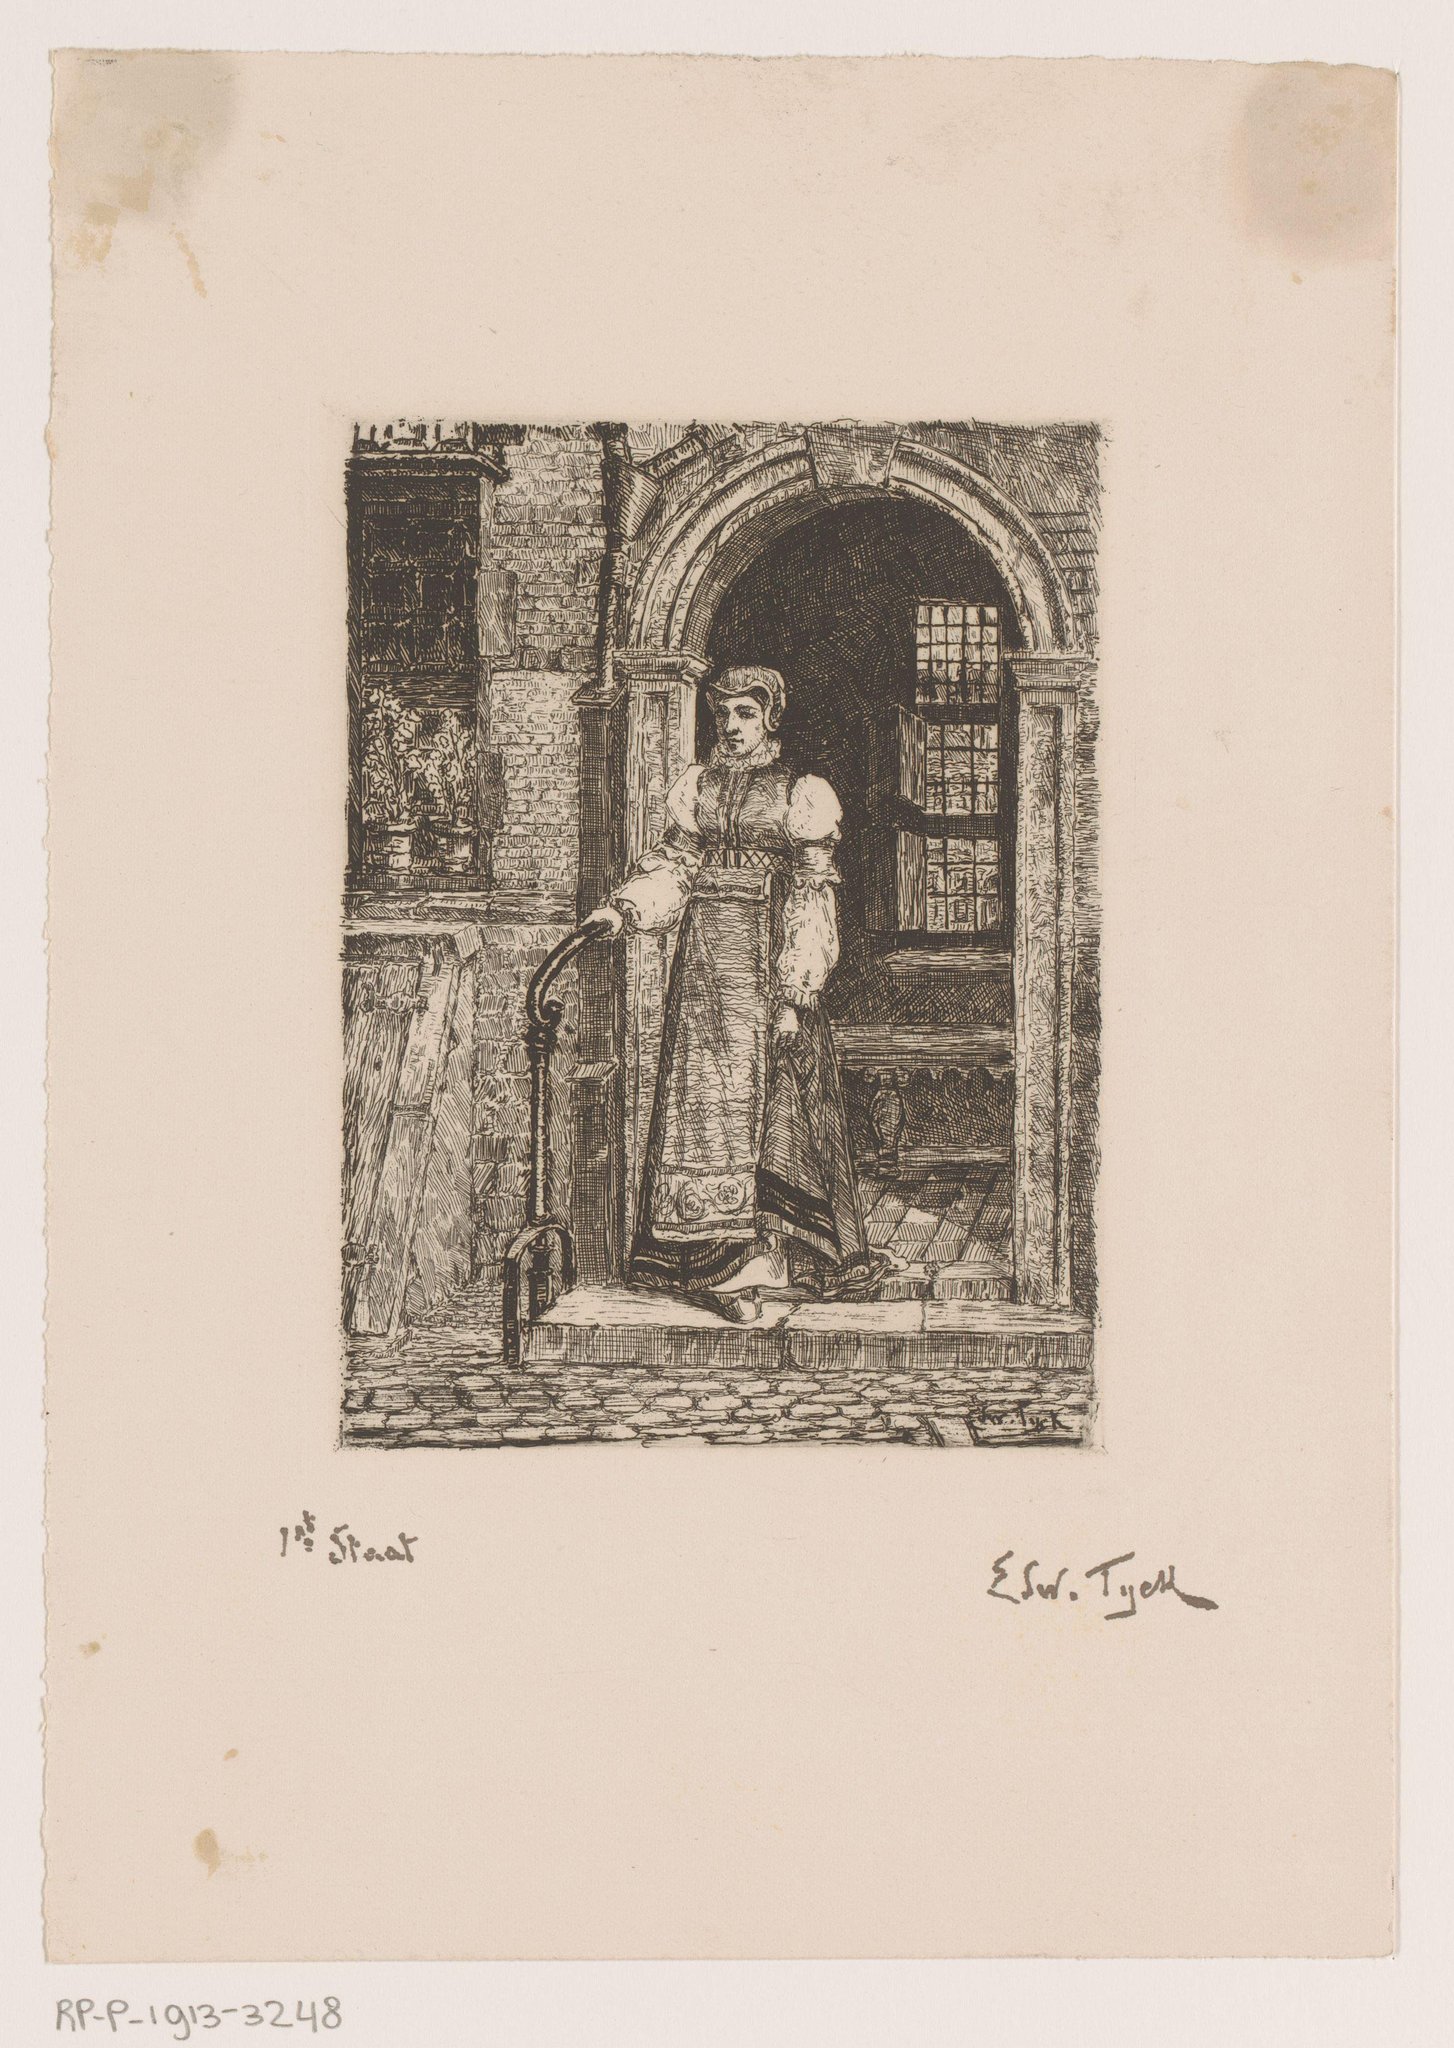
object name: print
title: Vrouw in een deuropening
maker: edouard tyck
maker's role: print maker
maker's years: 1847-1922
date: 1857-1913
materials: paper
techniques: drypoint, etching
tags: adult woman, open door, front steps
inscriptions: collector's mark: Lugt 2228